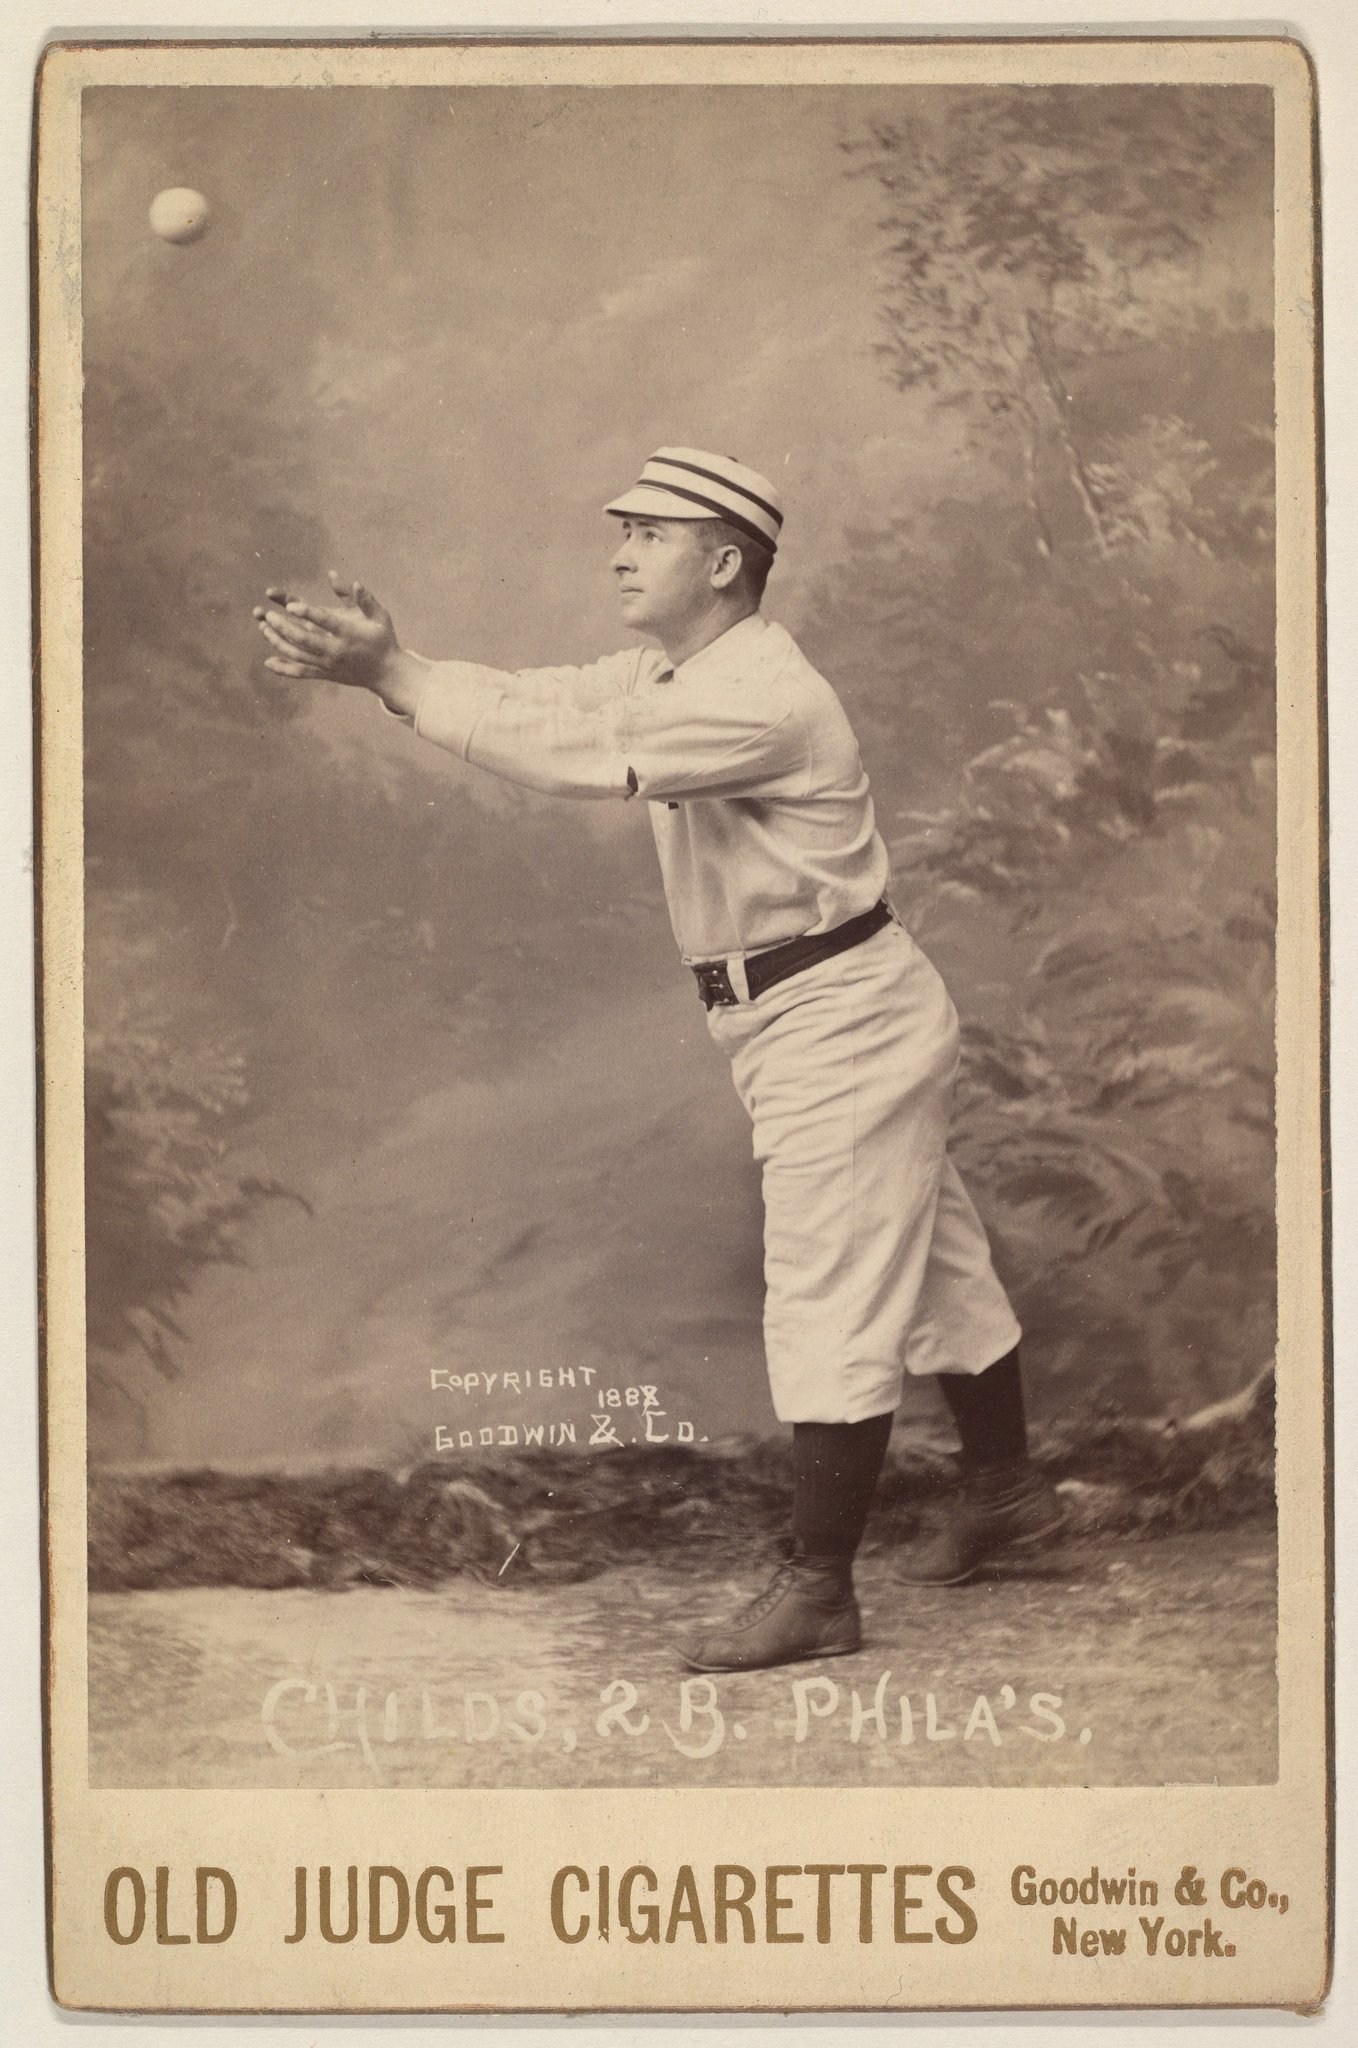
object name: baseball card, photograph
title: Childs, 2nd Base, Philadelphia, from the series Old Judge Cigarettes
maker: goodwin & company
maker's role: publisher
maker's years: 1850-1950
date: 1888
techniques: albumen silver print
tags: men,portraits,baseball,athletes